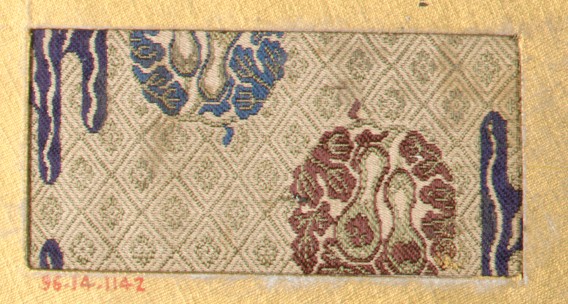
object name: piece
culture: japanese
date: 1701-1900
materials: silk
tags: gourds